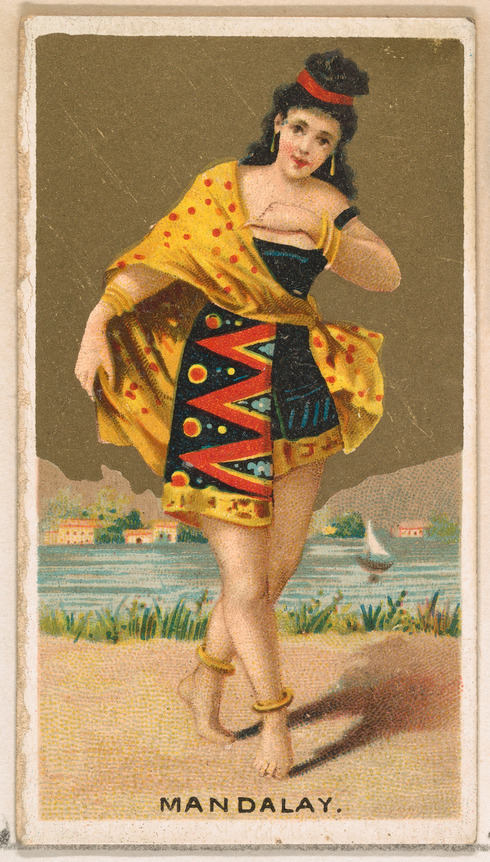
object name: print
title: Mandalay, from the Dancing Girls of the World series (N185) issued by Wm. S. Kimball & Co.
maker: william s. kimball & company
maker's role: publisher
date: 1889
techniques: color lithograph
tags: women,dancing